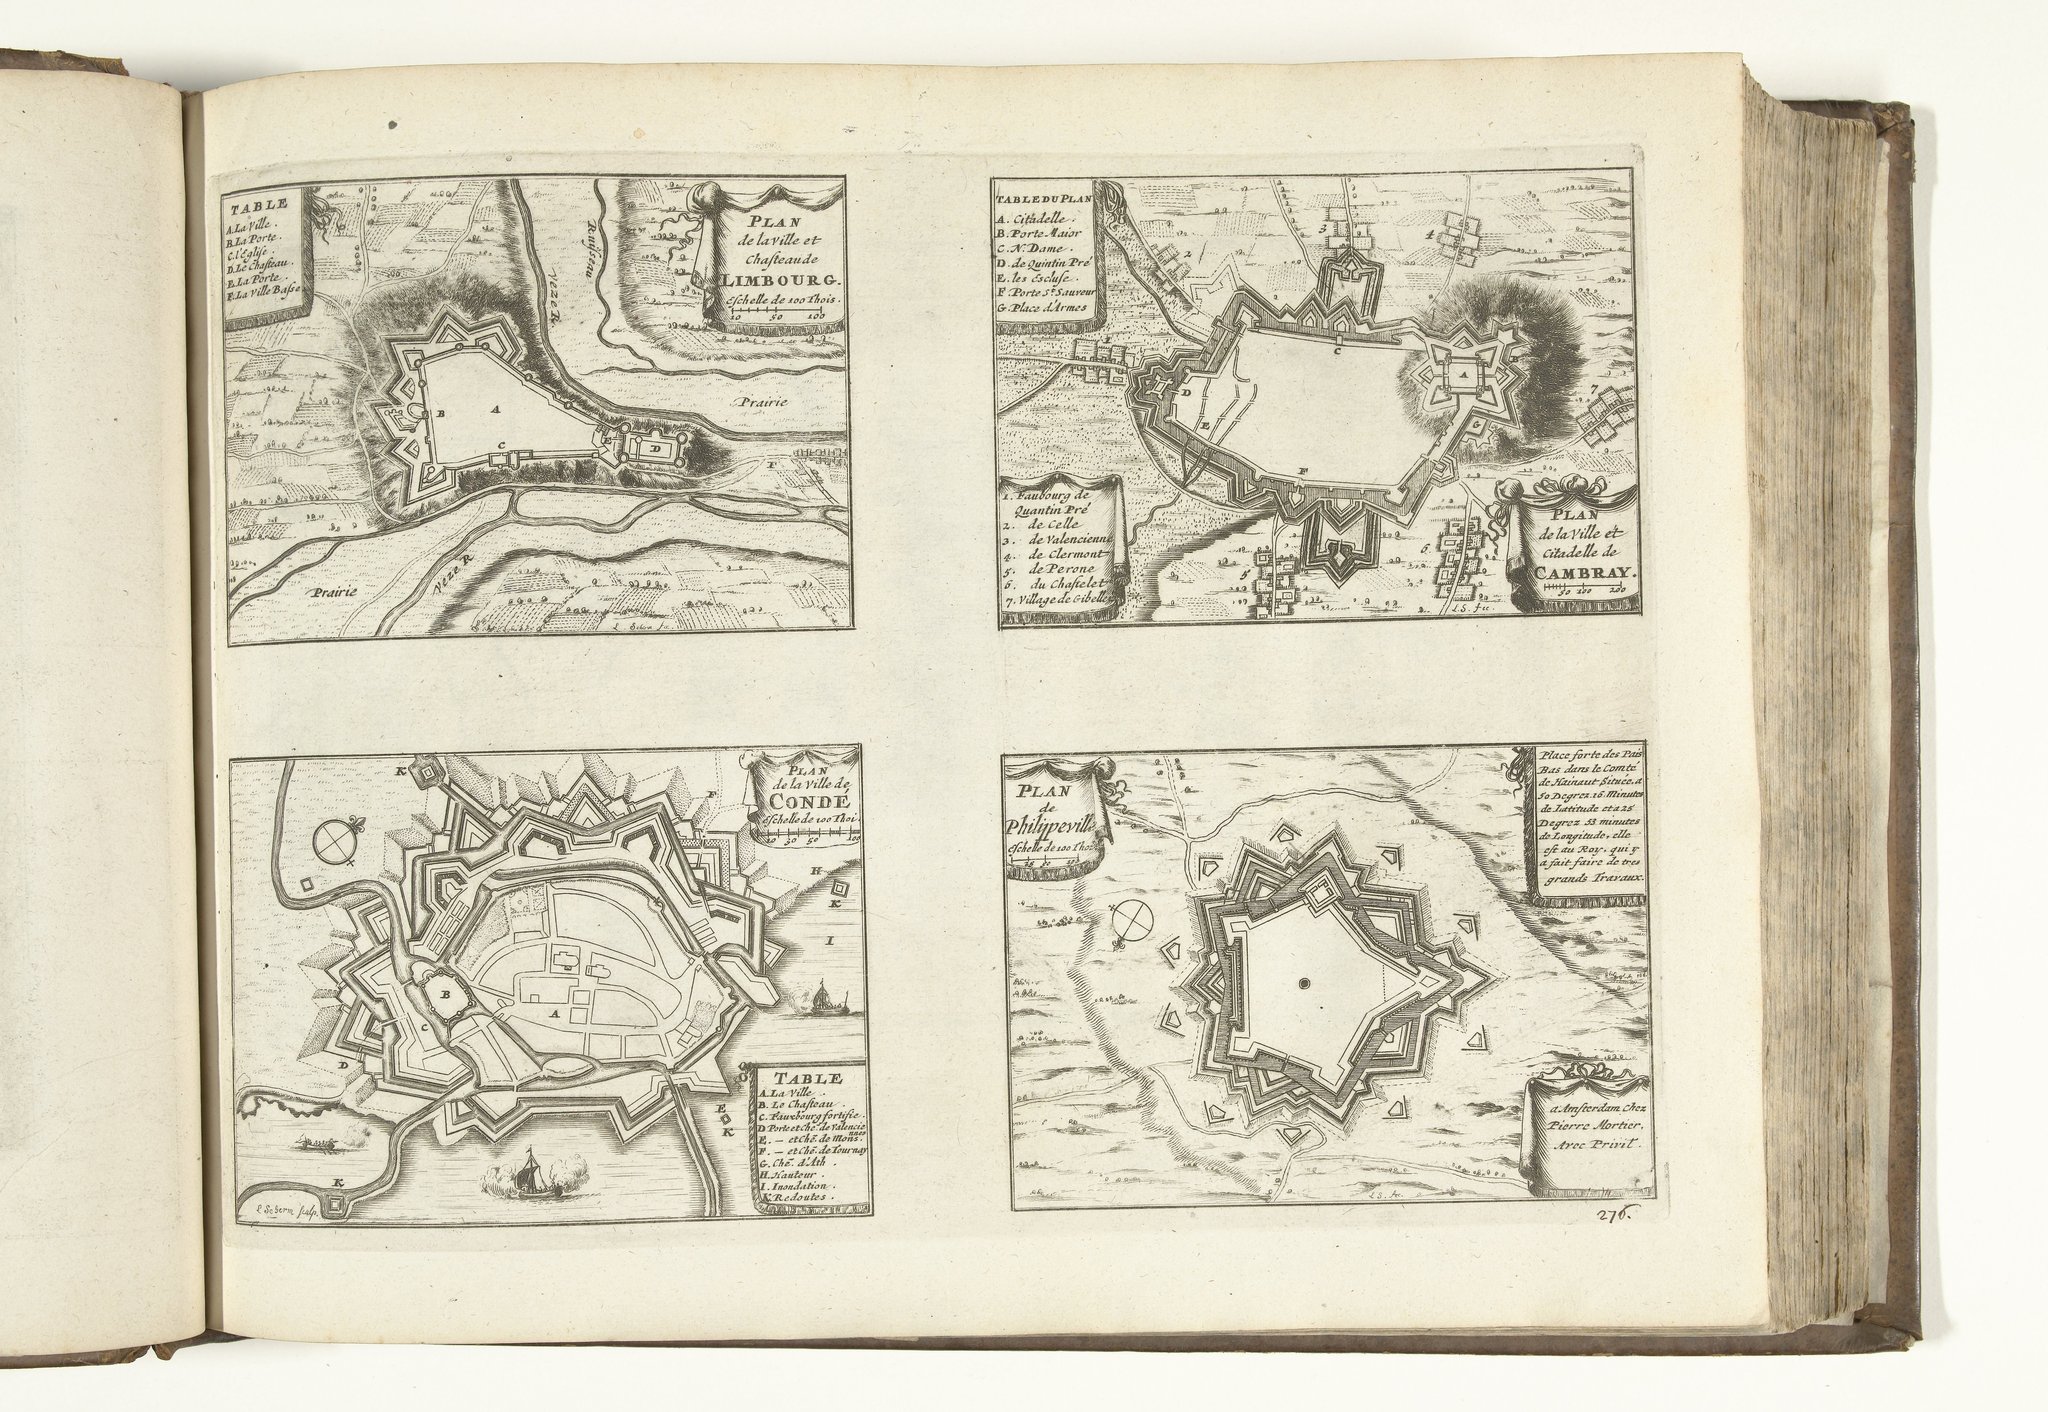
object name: map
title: Limbourg / Cambray / Condé / Philippeville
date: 1726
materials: paper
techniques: engraving, etching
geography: northern netherlands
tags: fortress, maps of cities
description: Blad met vier plattegronden van de versterkingen om de steden Limbourg, Cambrai (Kamerijk), Condé en Philippeville. Plaat nr. 276 in deel XII van het prentwerk: Les Forces de l'Europe, Asie, Afrique et Amerique ... Comme aussi les Cartes des Côtes de France et d'Espagne uit 1726, dit tweede deel met 271 met de hand genummerde platen van vermaarde sterke steden en vestingen in het kader van de Spaanse Successieoorlog 1701-1713. Voor het merendeel zijn deze platen gekopieerd naar de anonieme Franse platen van vermaarde sterke steden en vestingen: in Les forces de l'Europe en in: Le theatre de la guerre, dans les Pays-Bas, beide oorspronkelijk uitgegeven door Nicolas de Fer te Parijs (1693-1697) in het kader van de Negenjarige Oorlog. Titels en opschriften in het Frans.